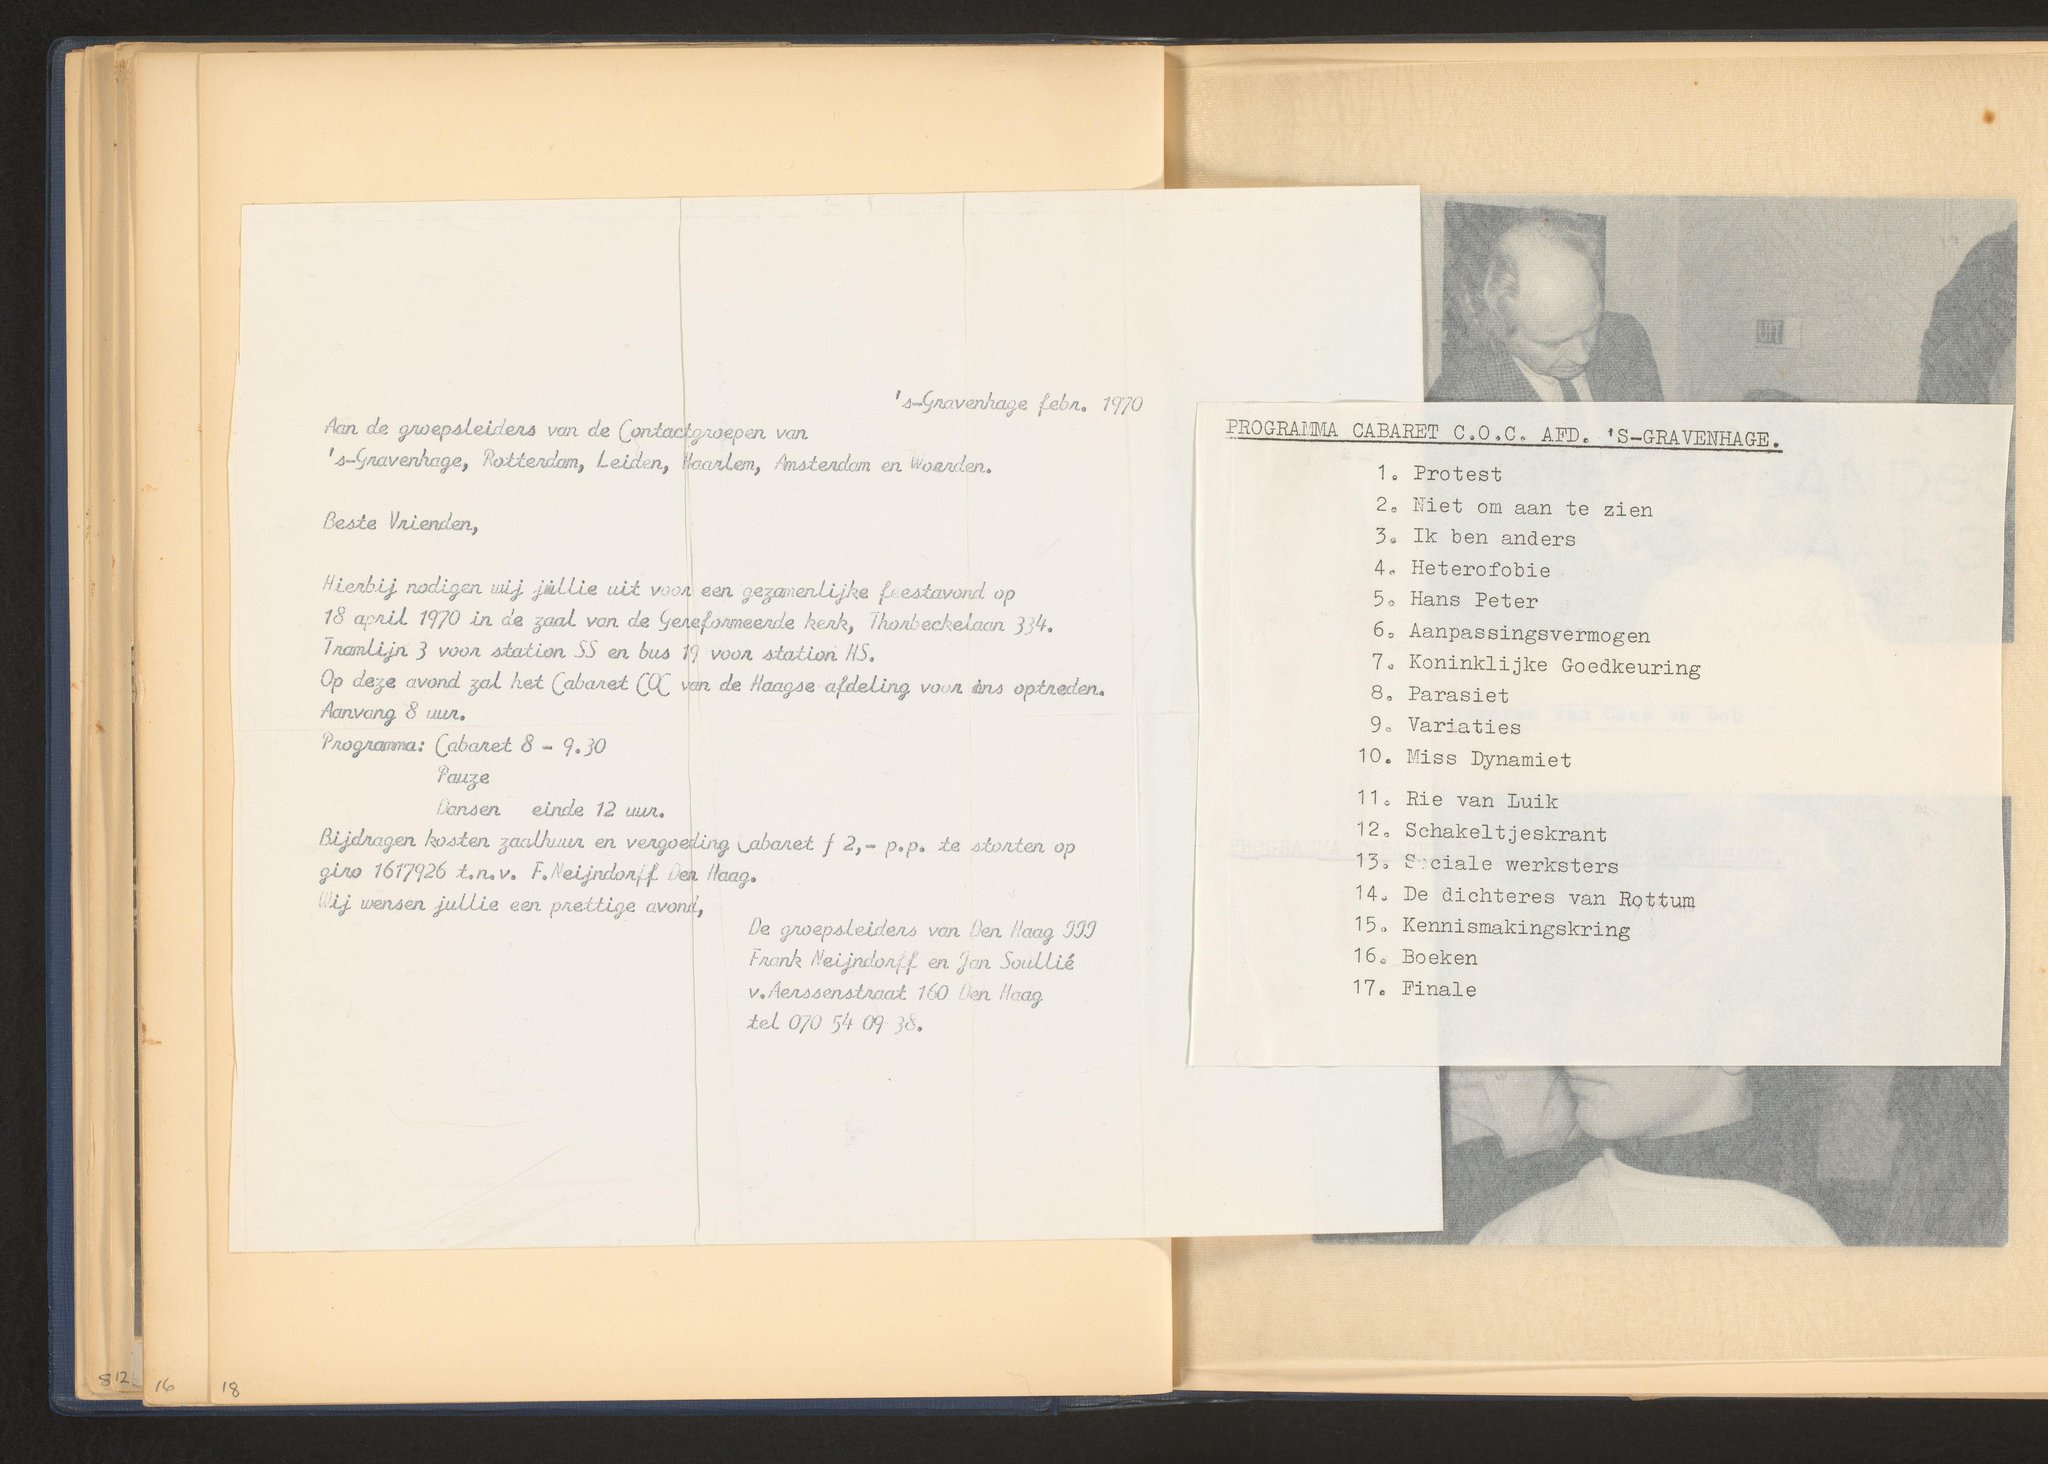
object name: album leaf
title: Uitnodiging en programma voor cabaretvoorstelling verzorgd door leden van het COC afdeling Den Haag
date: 1970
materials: cardboard, paper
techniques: mimeography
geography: the hague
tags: the hague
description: Albumblad waarop zijn geplakt een uitnodiging en het programma voor een cabaretvoorstelling verzorgd door leden van het COC afdeling Den Haag. De uitnodiging is voor een optreden op 18 april 1970 in Den Haag. Onderdeel van het fotoalbum van cabaretvoorstellingen COC 1968-1974, afdeling Den Haag.